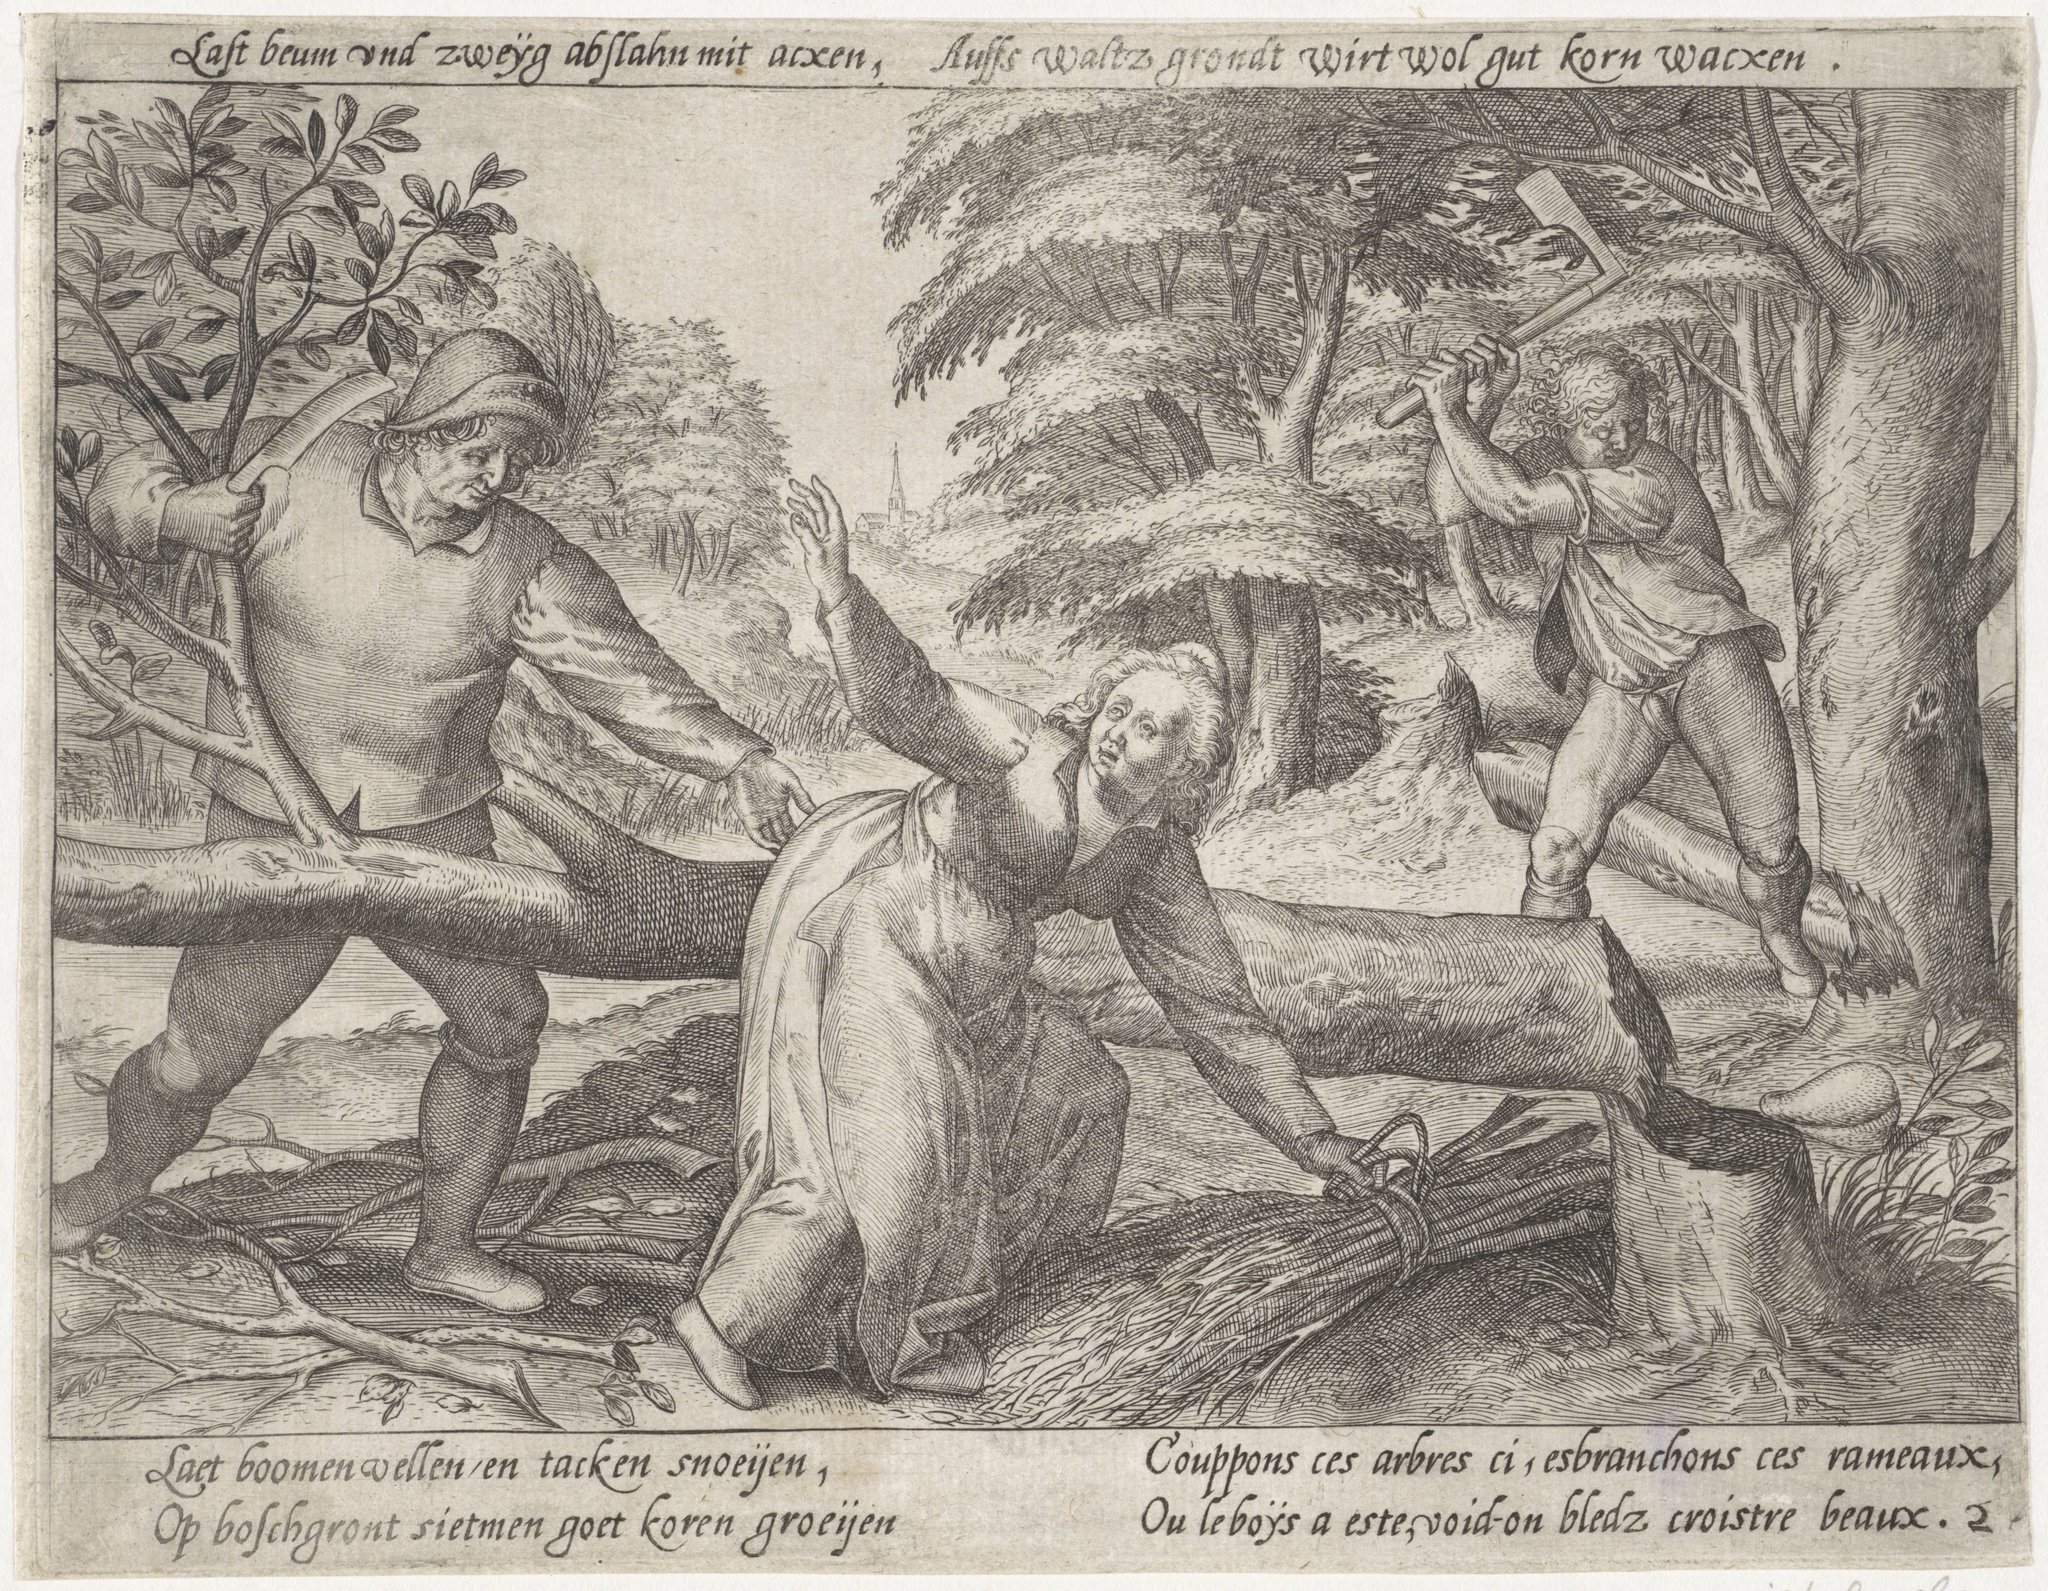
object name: print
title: Het verbouwen van graan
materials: paper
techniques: engraving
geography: antwerp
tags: soil cultivation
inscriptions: collector's mark: Lugt 2228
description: Mannen en vrouwen zijn bezig met het omhakken van bomen en het bijeen binden van de takken. Ze maken het gebied geschikt voor de landbouw. Op de prent een toelichting op de voorstelling in het Duits, het Nederlands en het Frans.